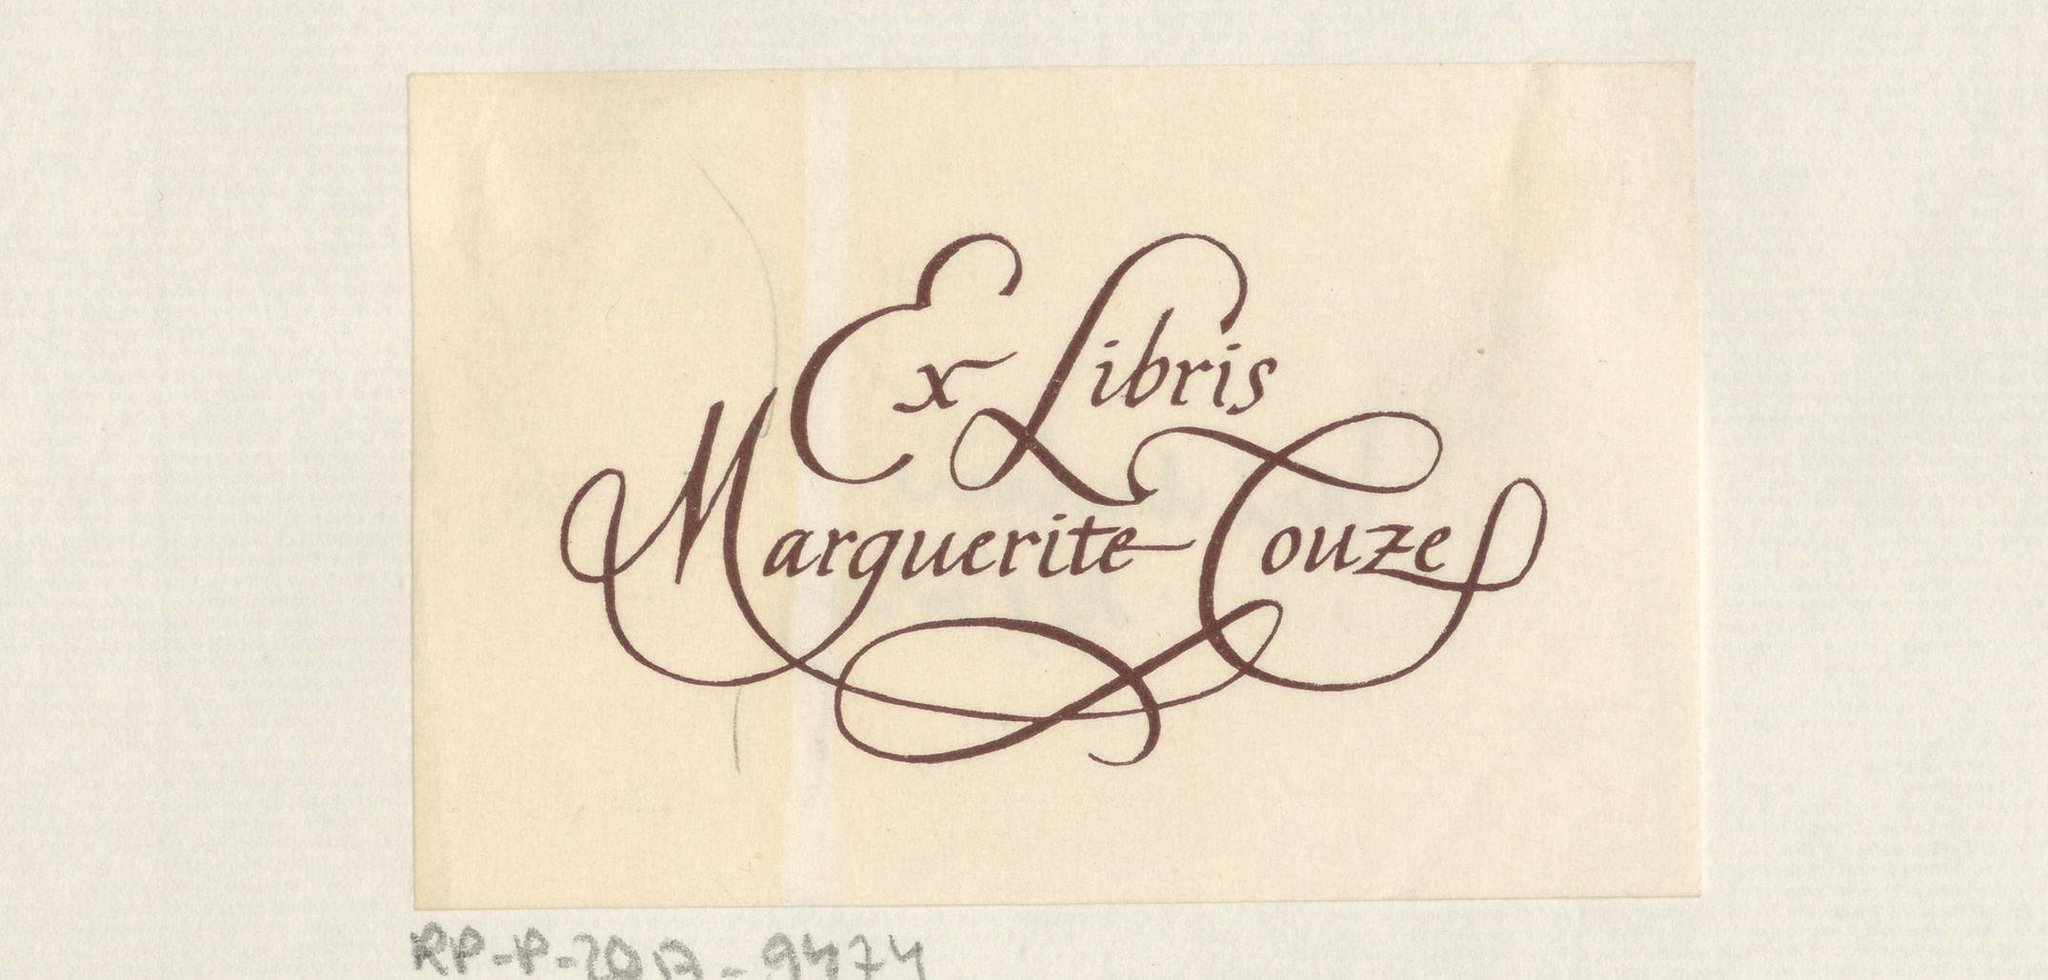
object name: bookplate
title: Ex libris van Marguerite Couze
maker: Anonymous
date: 1900-1999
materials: paper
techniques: printing block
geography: france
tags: marguerite couze